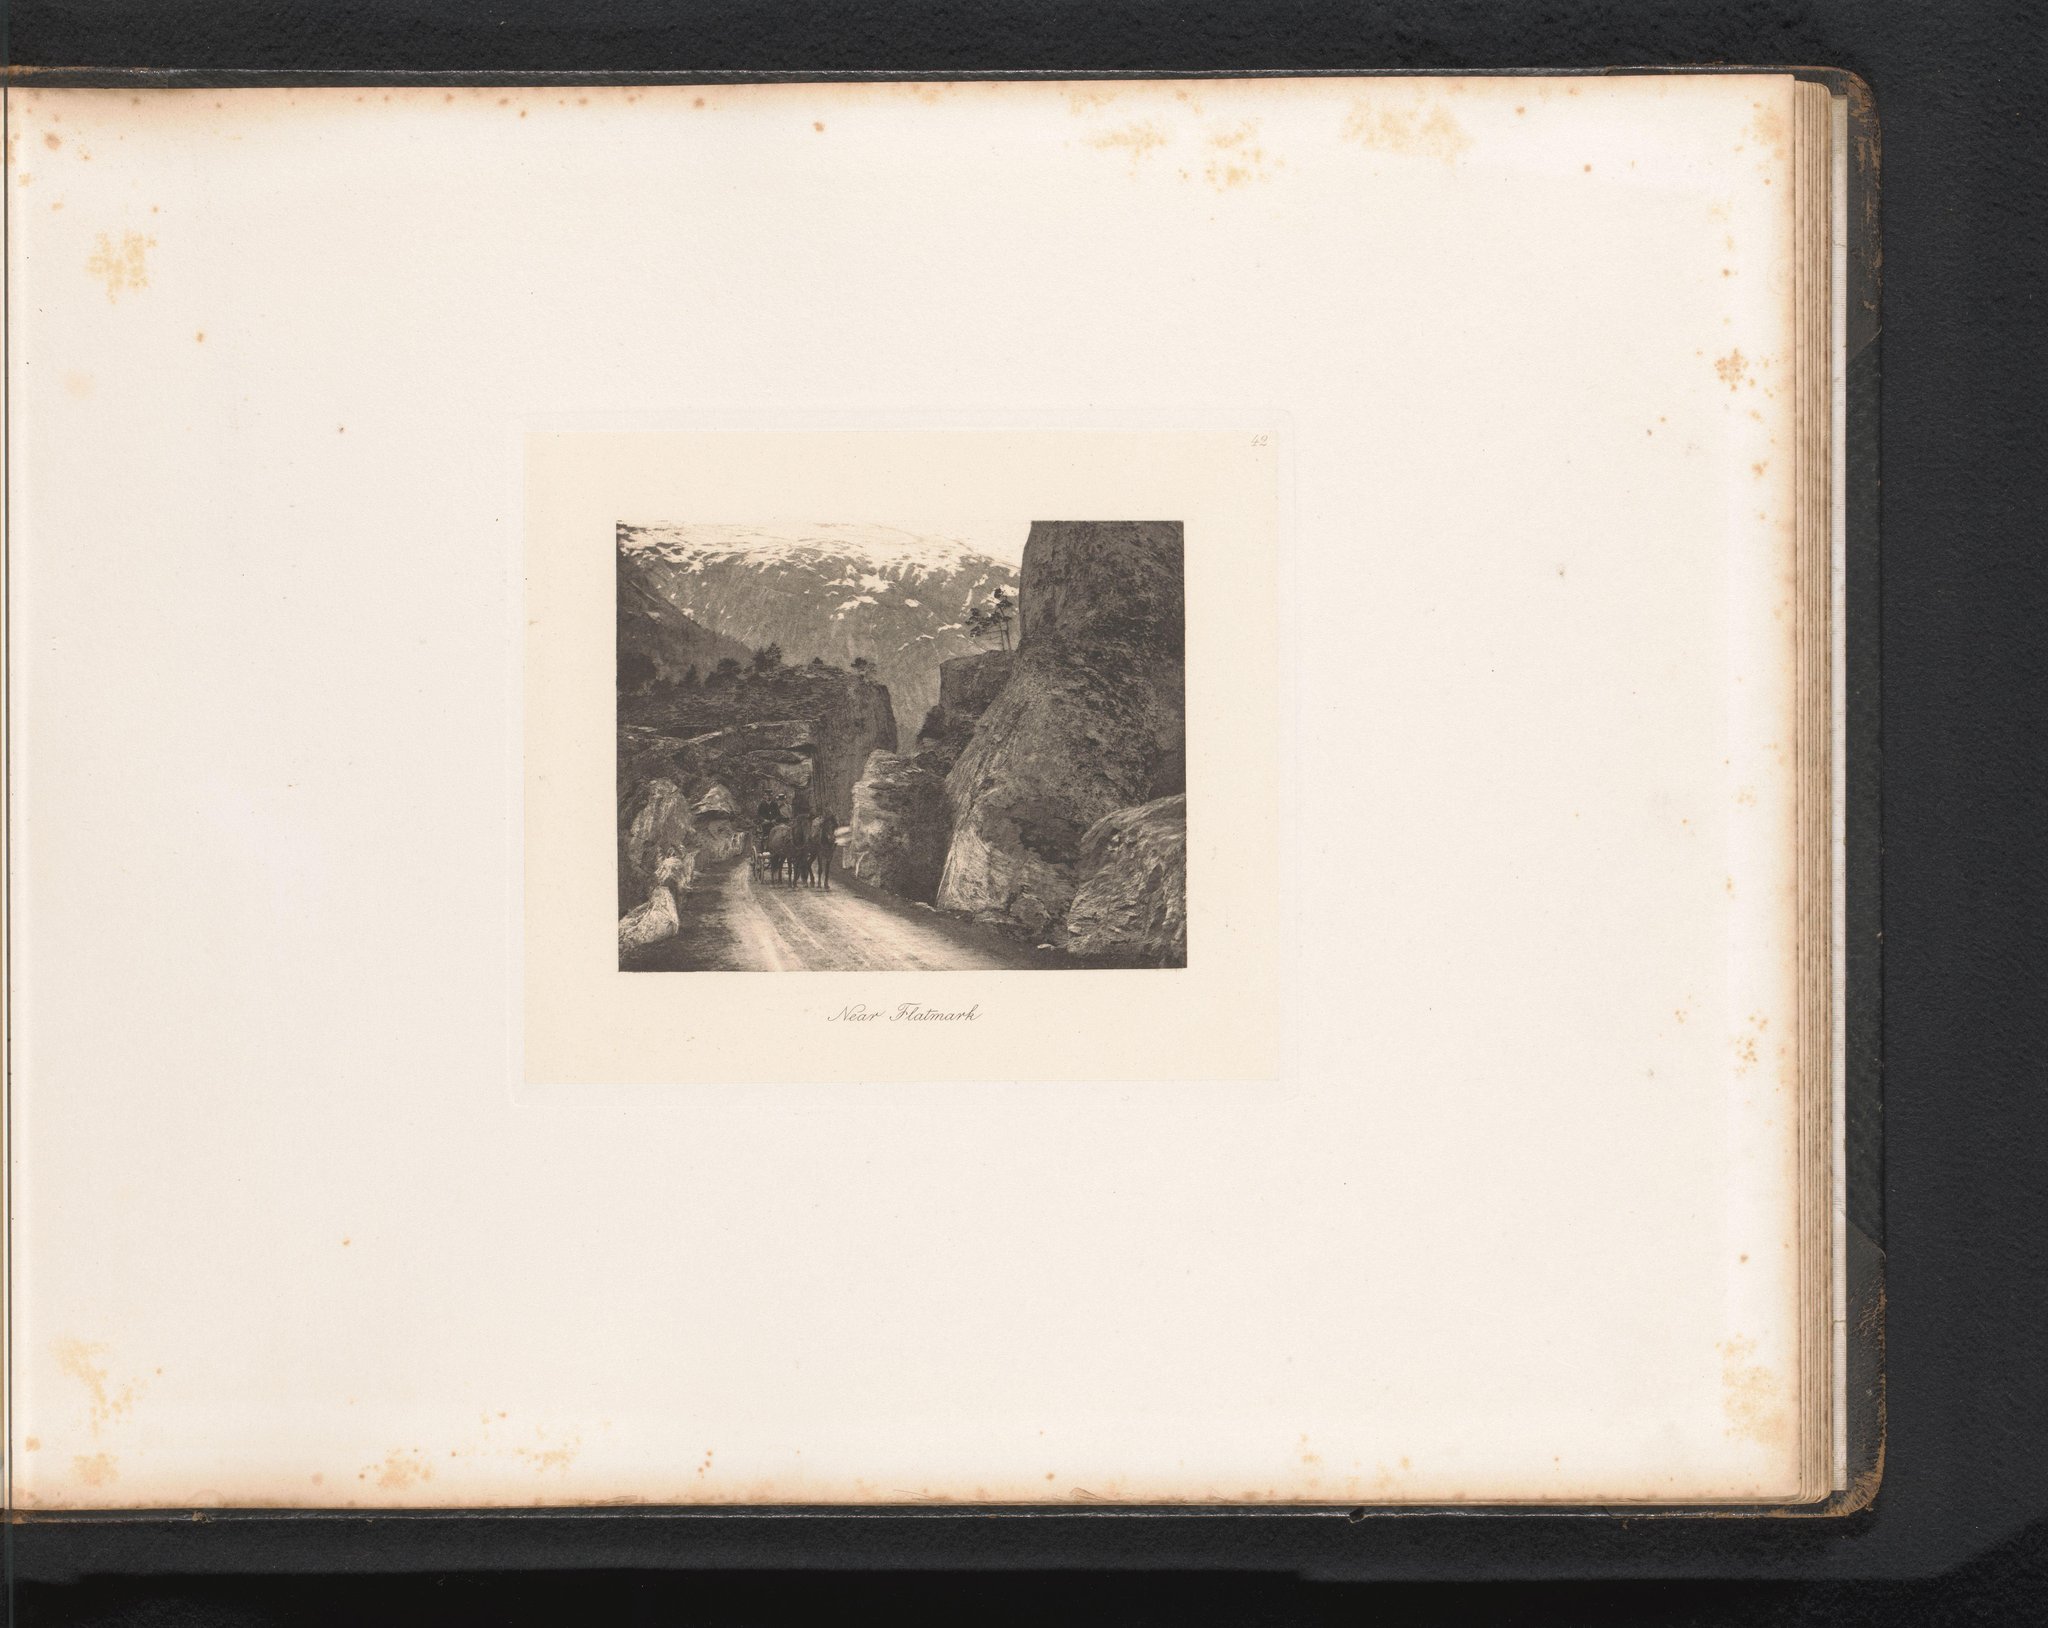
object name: photomechanical print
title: Near Flatmark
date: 1888-1893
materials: paper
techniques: photograph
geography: møre og romsdal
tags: mountains (+ landscape with figures, staffage), passenger carriage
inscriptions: number: ‘42’